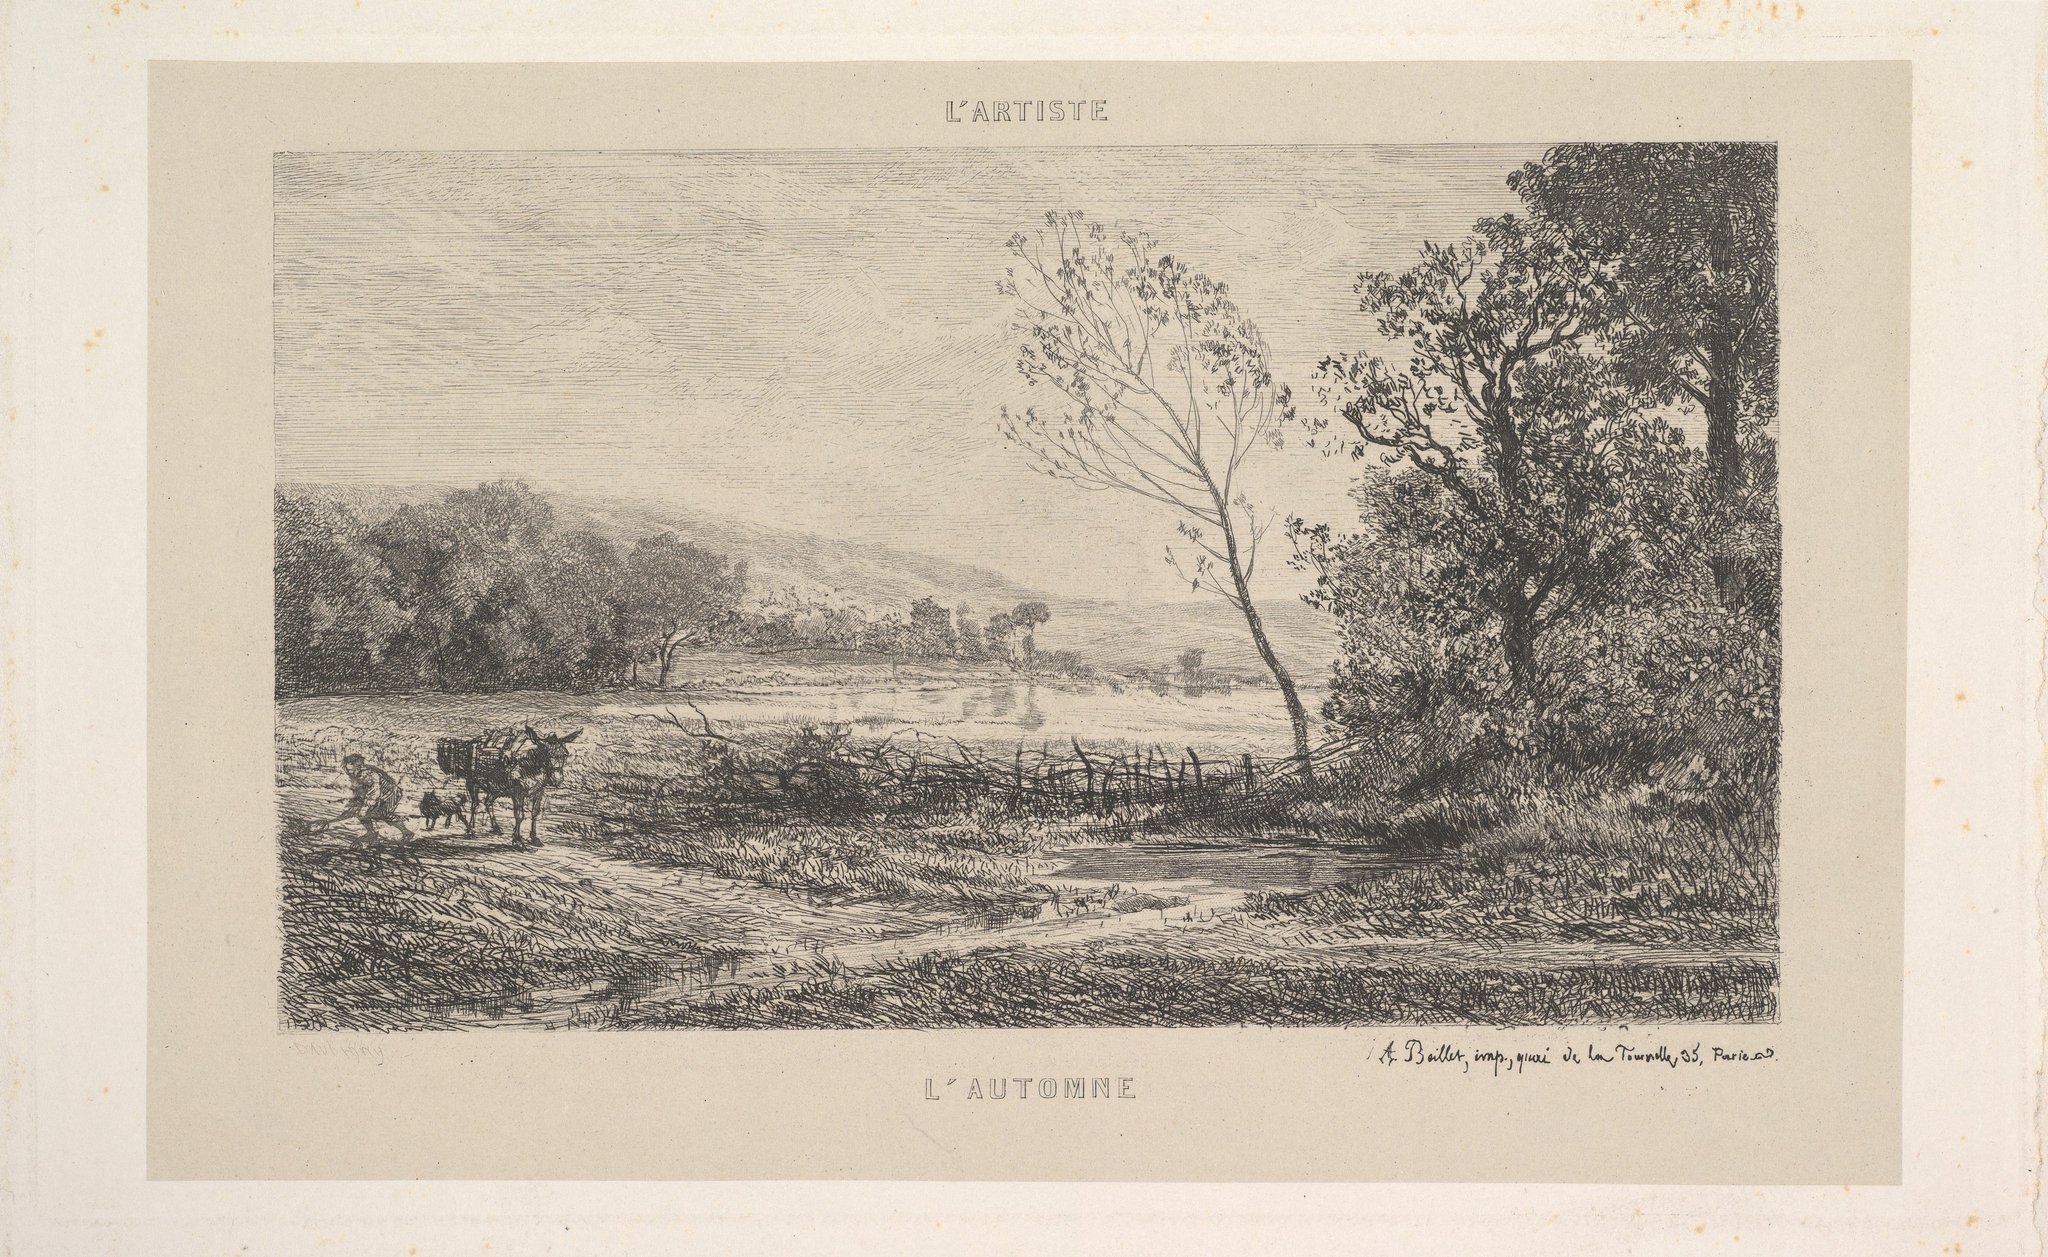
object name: print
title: Autumn, from "L'Artiste"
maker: charles-françois daubigny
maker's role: artist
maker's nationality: french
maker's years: 1817-1878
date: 1848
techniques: etching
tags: human figures,animals,trees,autumn